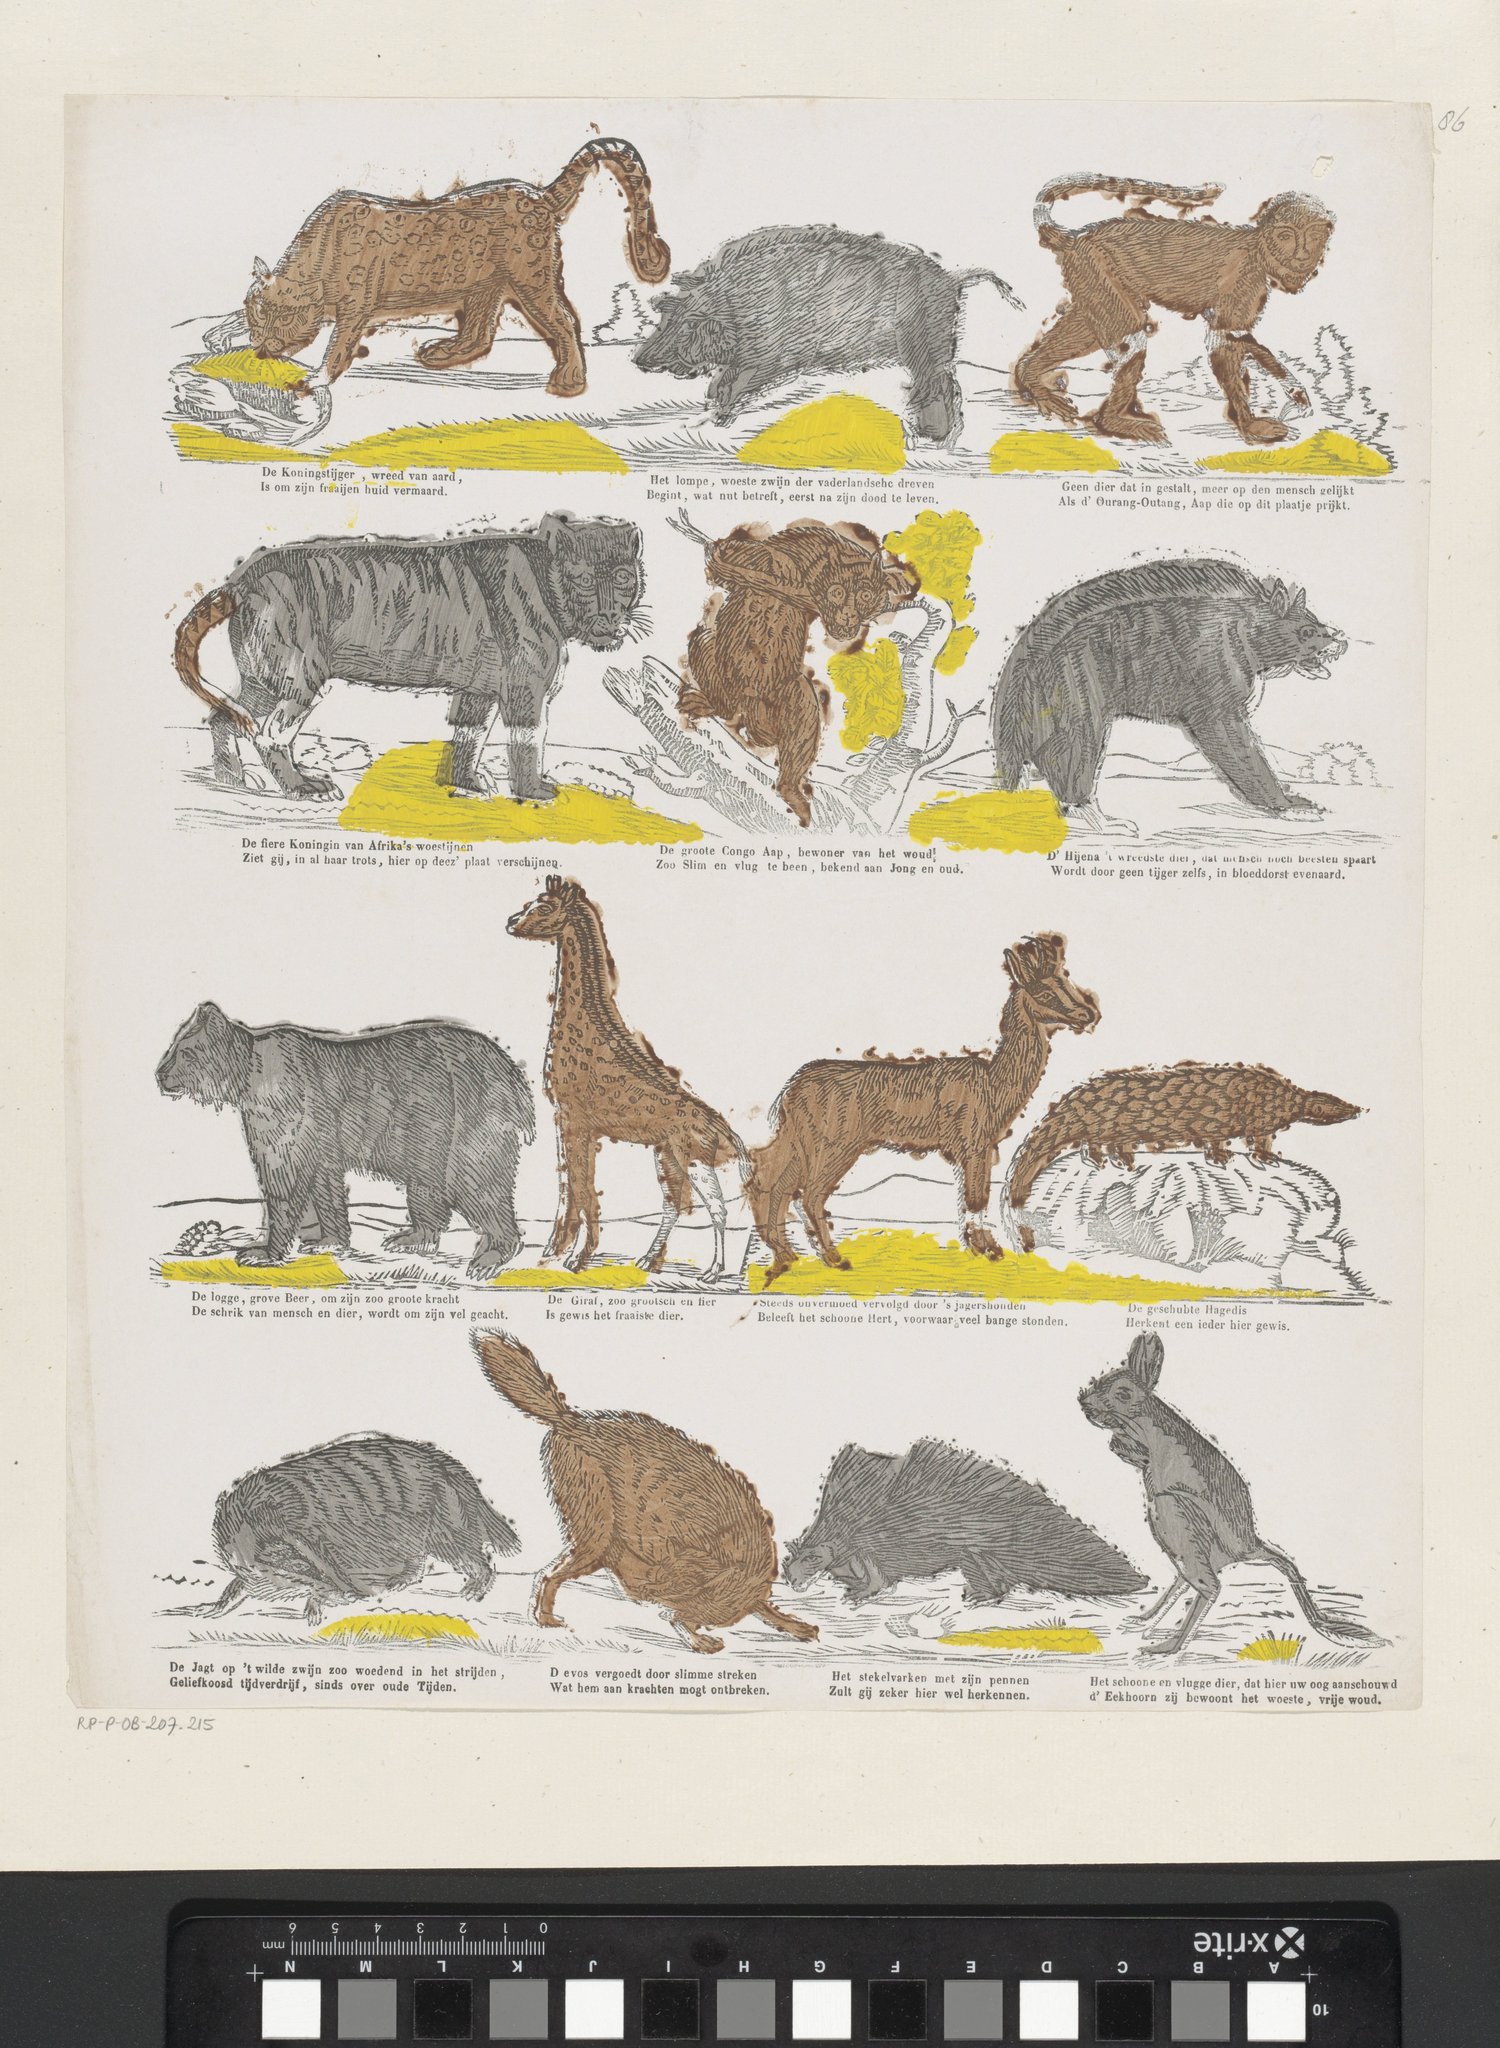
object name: print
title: Dieren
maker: Anonymous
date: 1848-1881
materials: paper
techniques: colour, letterpress printing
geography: den bosch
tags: beasts of prey, predatory animals: tiger, animals, monkeys, apes, beasts of prey, predatory animals: bear, hoofed animals: giraffe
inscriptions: collector's mark: Lugt 2760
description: Blad met 4 horizontale rijen met voorstellingen van dieren, zoals een tijger, een aap en een giraffe. Onder elke afbeelding een tweeregelig onderschrift.